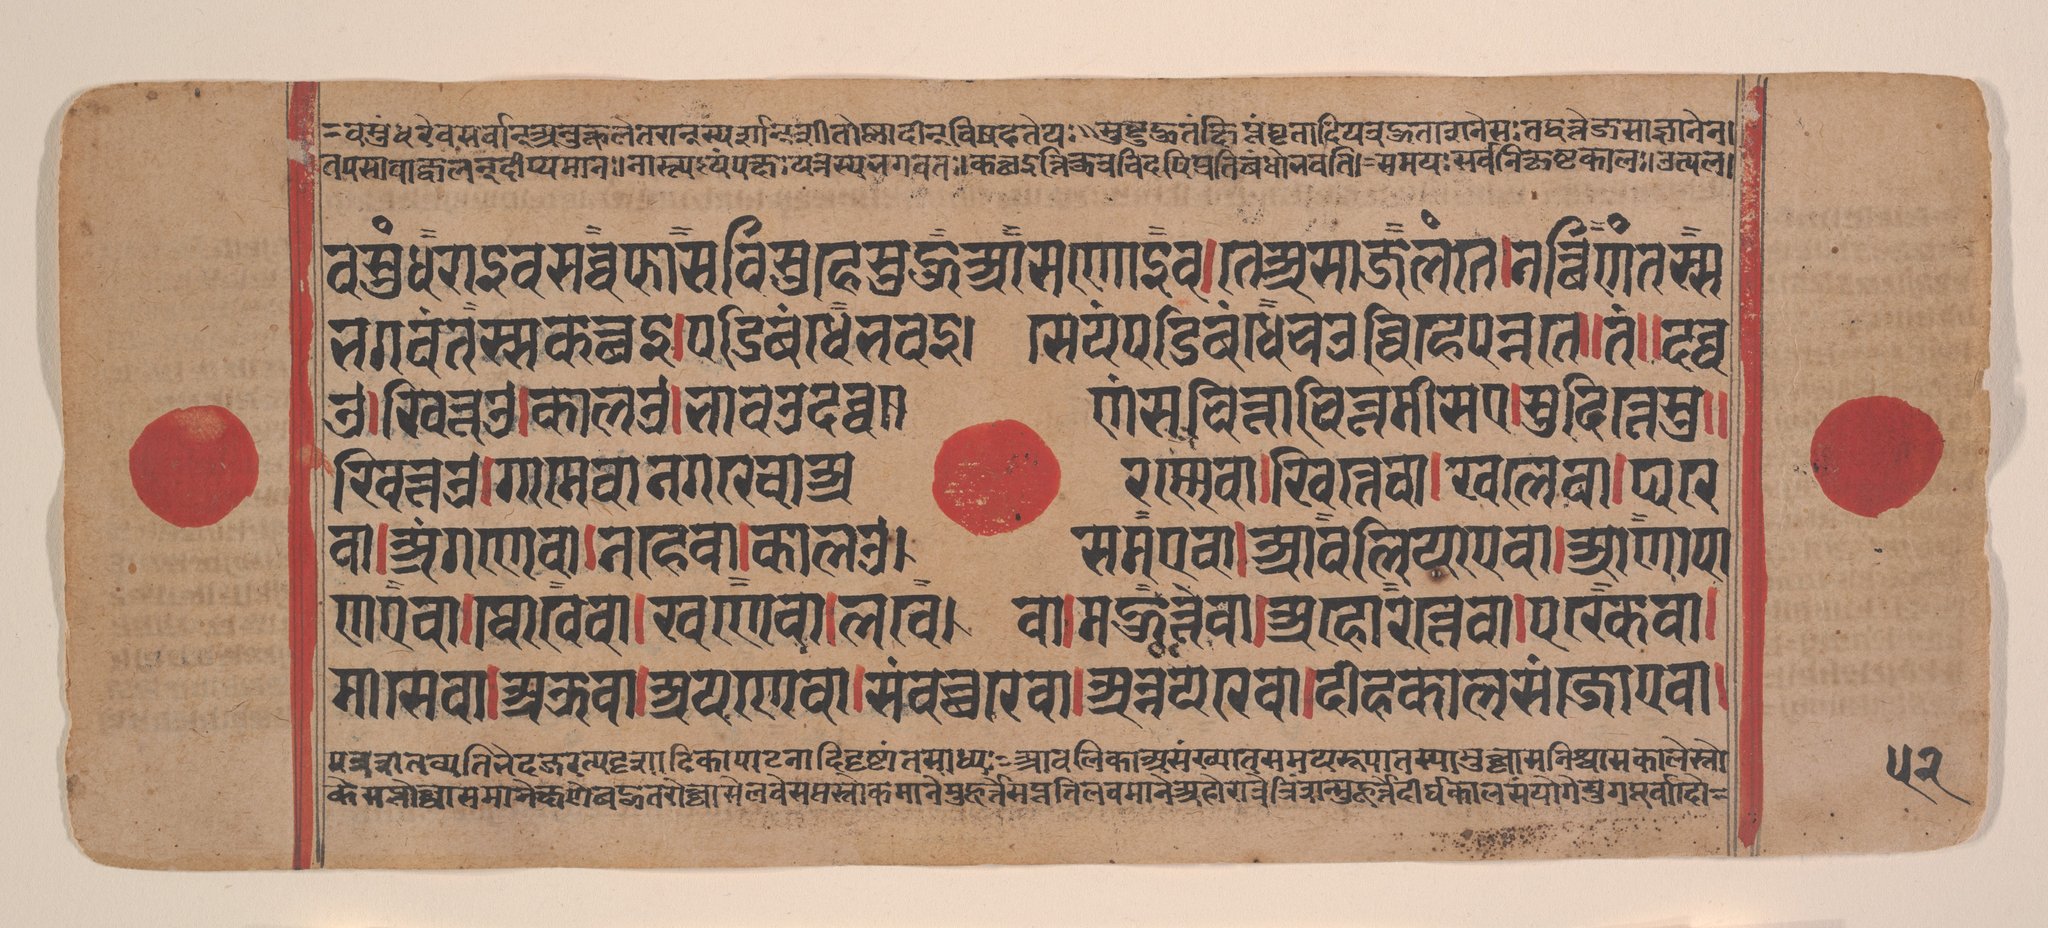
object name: folio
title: Page from a Dispersed Kalpa Sutra (Jain Book of Rituals)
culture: indian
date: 1401-1500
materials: gold, ink, paper, watercolor